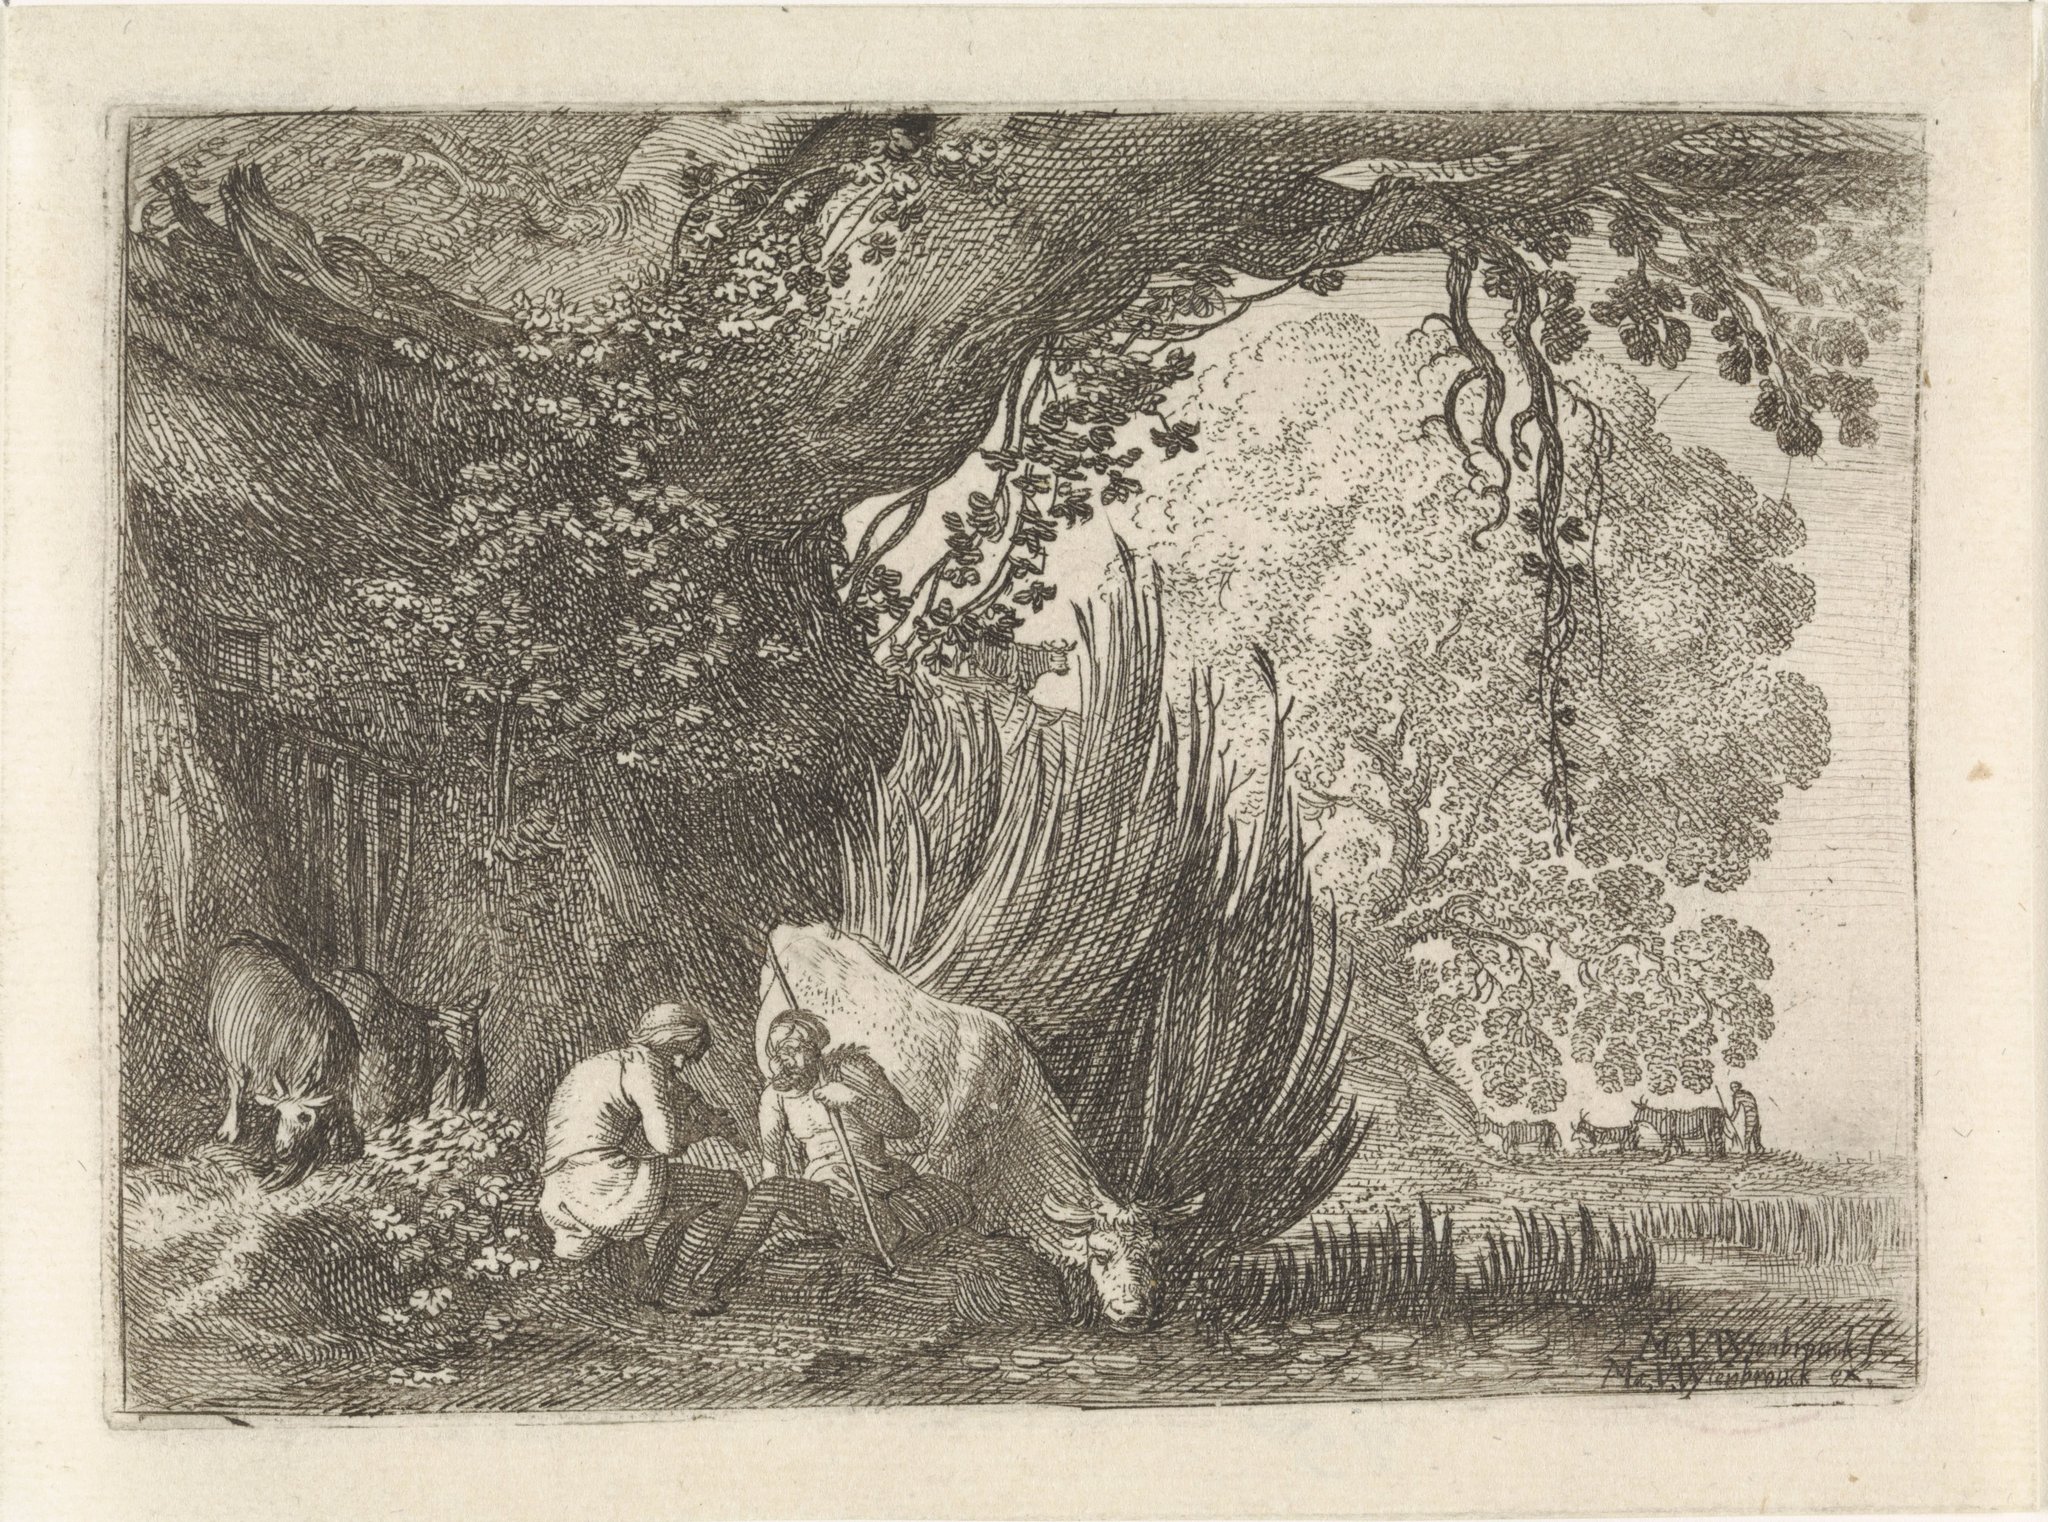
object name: print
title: Mercurius sust Argus in slaap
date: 1600-1647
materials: paper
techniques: engraving, etching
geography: the hague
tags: mercury lulls argus into sleep by making music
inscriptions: collector's mark: Lugt 240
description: Mercurius speelt fluit voor de in slaap vallende Argus. De koe Io drinkt uit een vijver. Scène uit Ovidius’ Metamorfosen (Met. I, 682-687).